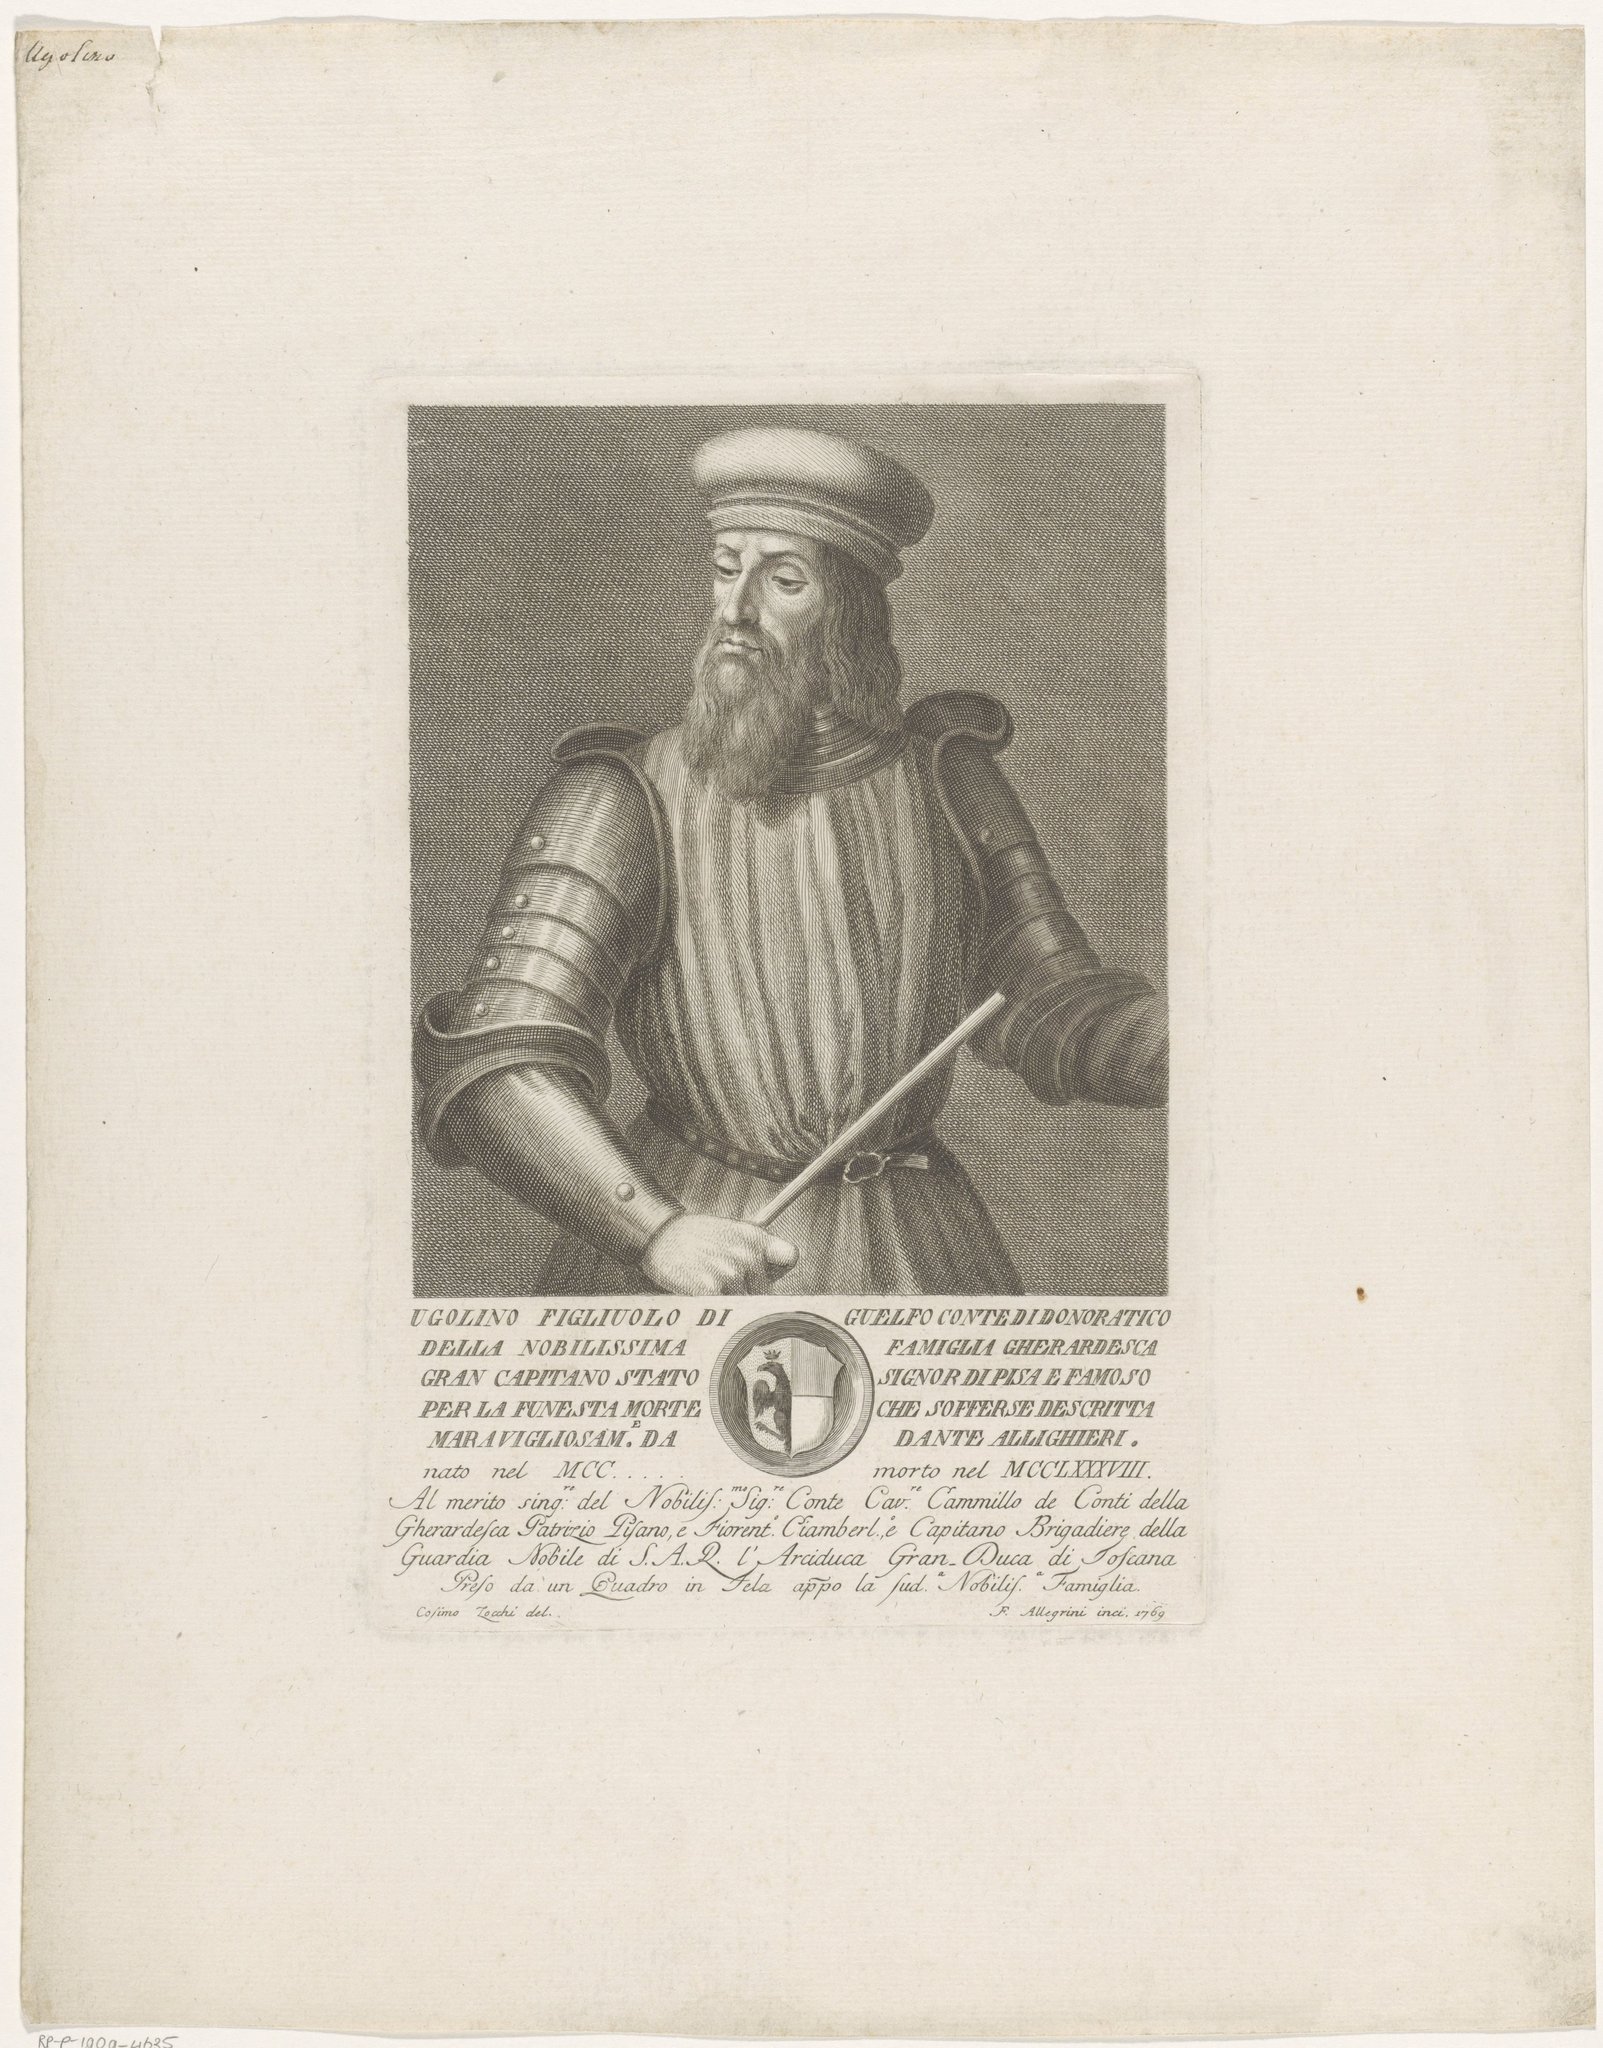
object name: print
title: Portret van Ugolino della Gherardesca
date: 1769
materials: paper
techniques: engraving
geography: italy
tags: politician, historical persons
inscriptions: inscription: ‘Ugolino’, collector's mark: Lugt 2228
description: Portret van Ugolino della Gherardesca ten halven lijve. Onder het portret een tekst in het Italiaans en een wapenschild in een cirkelvormig kader.